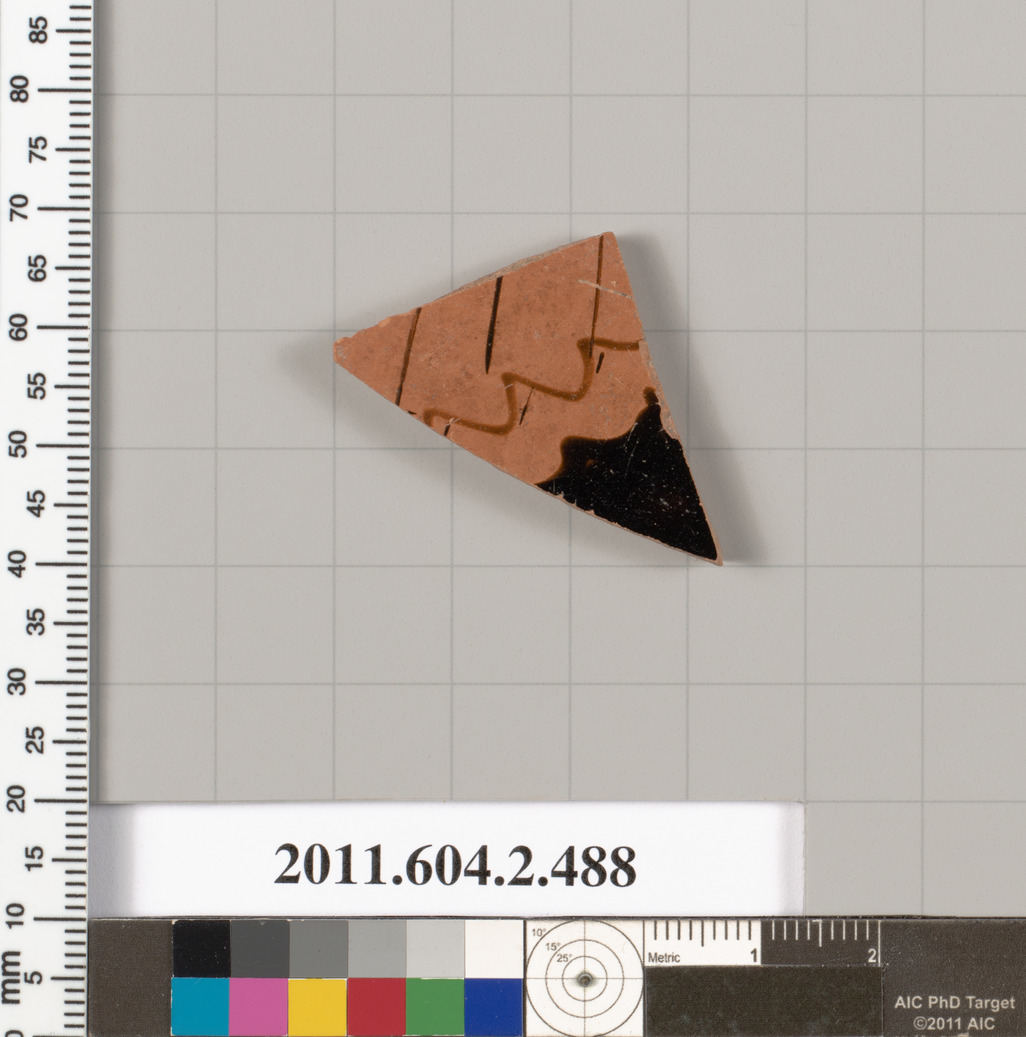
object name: column krater fragment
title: Terracotta fragment of a column-krater (bowl for mixing wine and water)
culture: greek, attic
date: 460-440 BCE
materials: terracotta